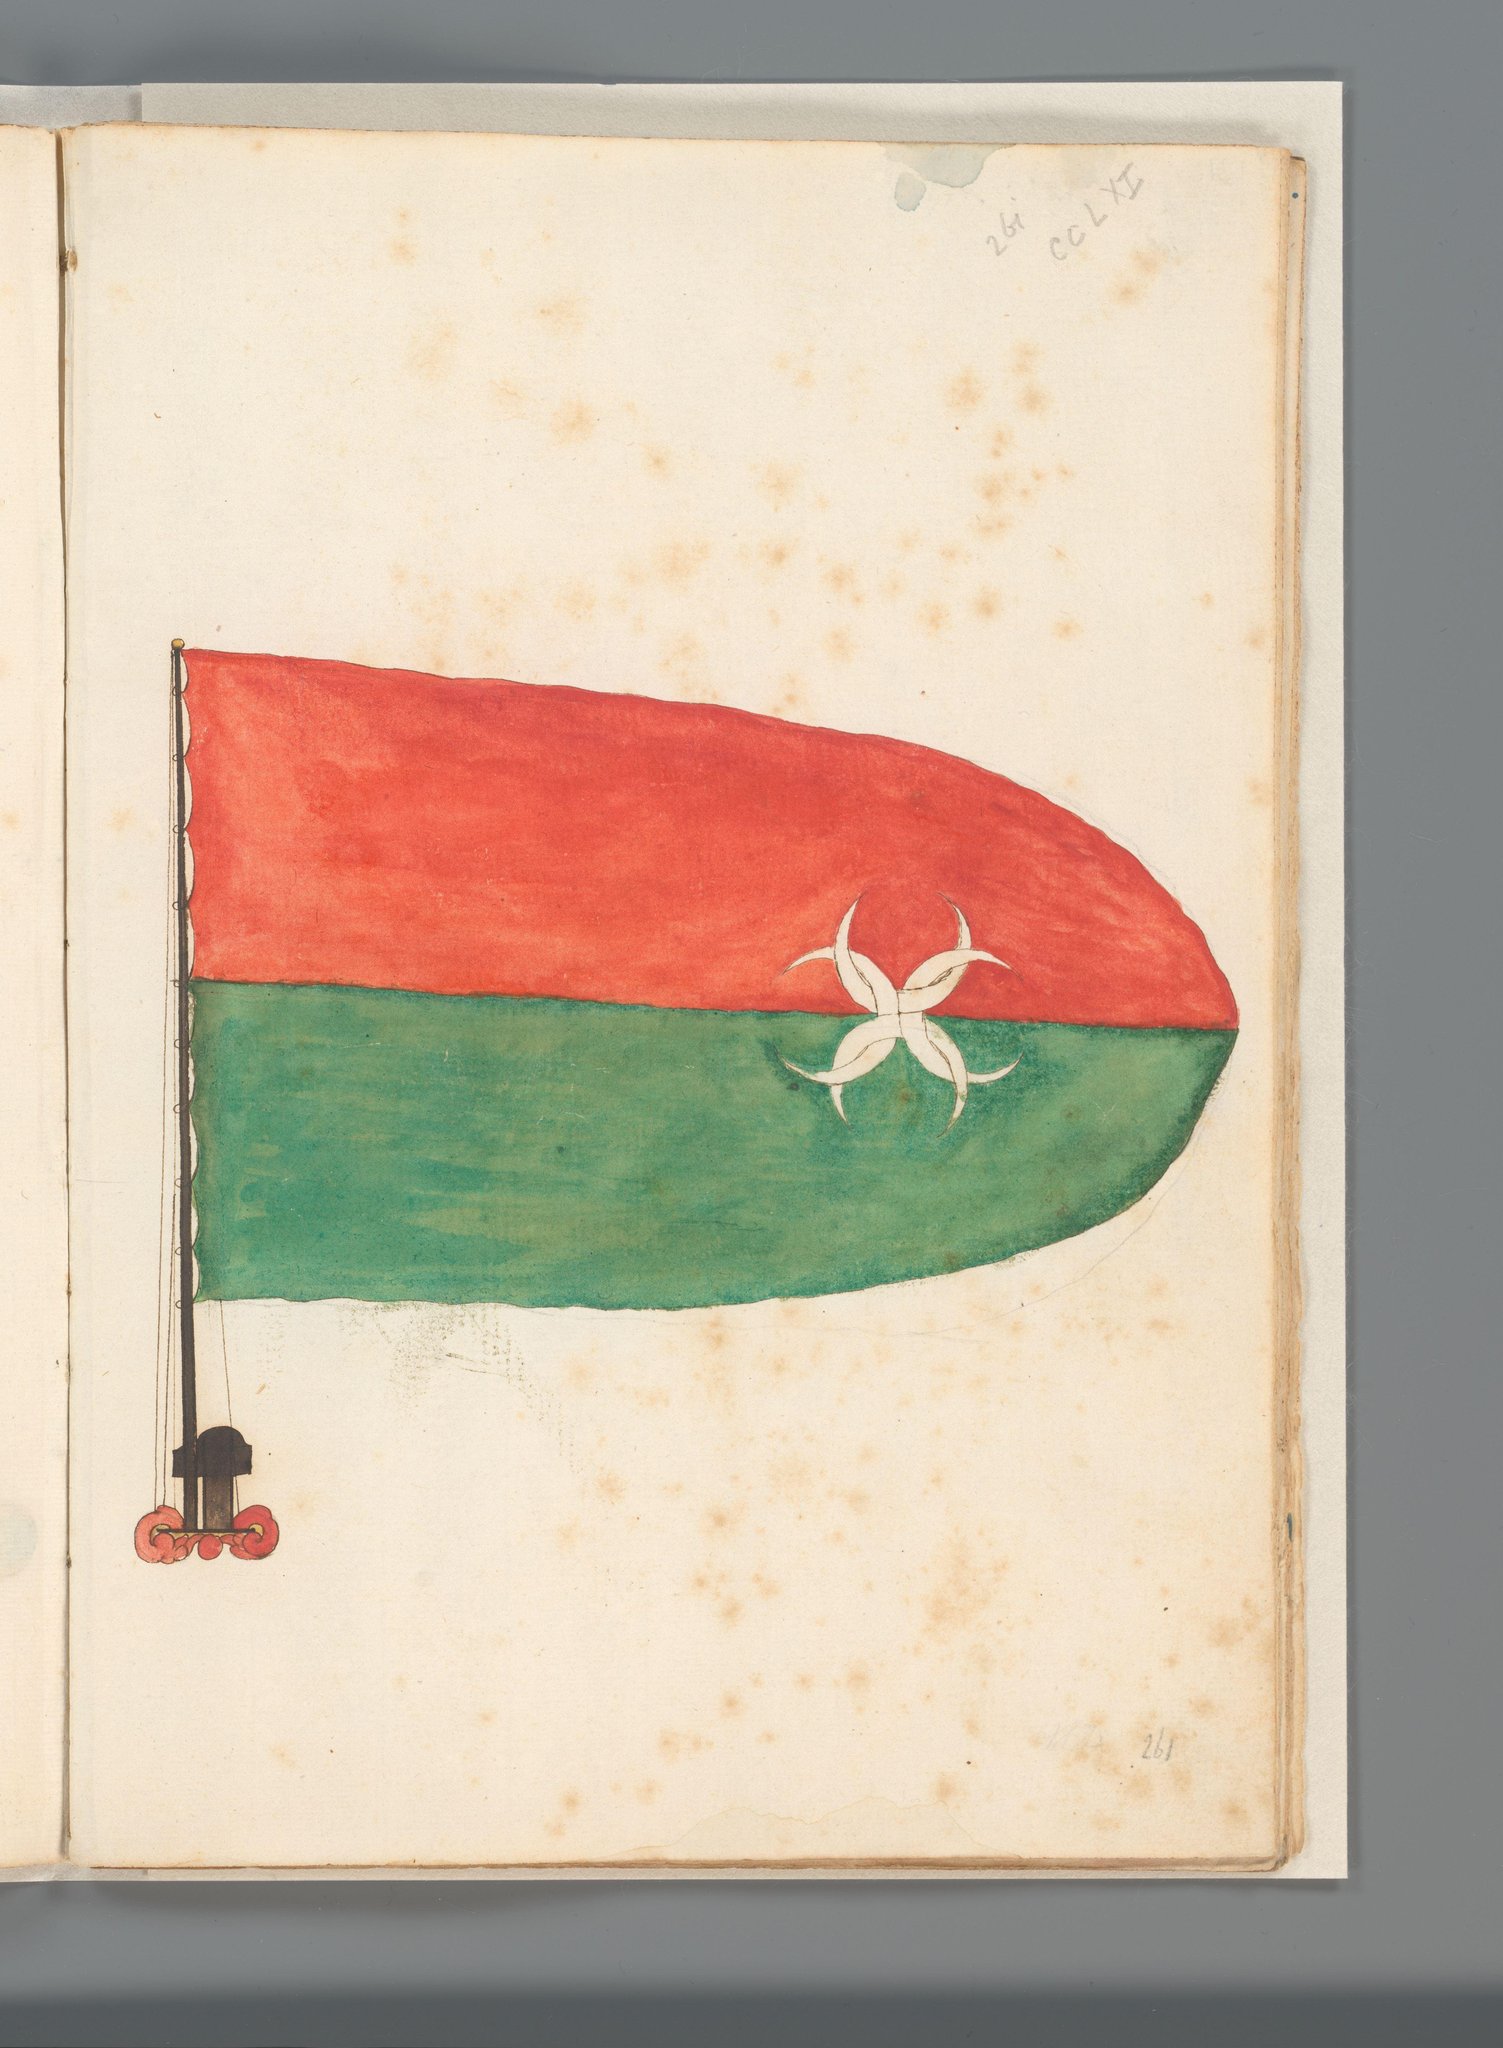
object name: drawing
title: Vlag van Turkije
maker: Anonymous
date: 1667-1670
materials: ink, paper, watercolor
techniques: brush, pen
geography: france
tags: flag, colours (as symbol of the state, etc.)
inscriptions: number: ‘261 / CCLXI / 261’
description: Vlag van Turkije (Ottomaanse Rijk). Vlag met twee horizontale banen in rood en groen waarop rechts vier verstrengelde halve manen, met afgeronde vluchtzijde. Vlag op vlaggensteng en mastvoet. Afgebeeld op folio 131r. Onderdeel van een vlaggenboek met vlaggen uit Europa, Noord-Afrika, Nabije en Verre Oosten.